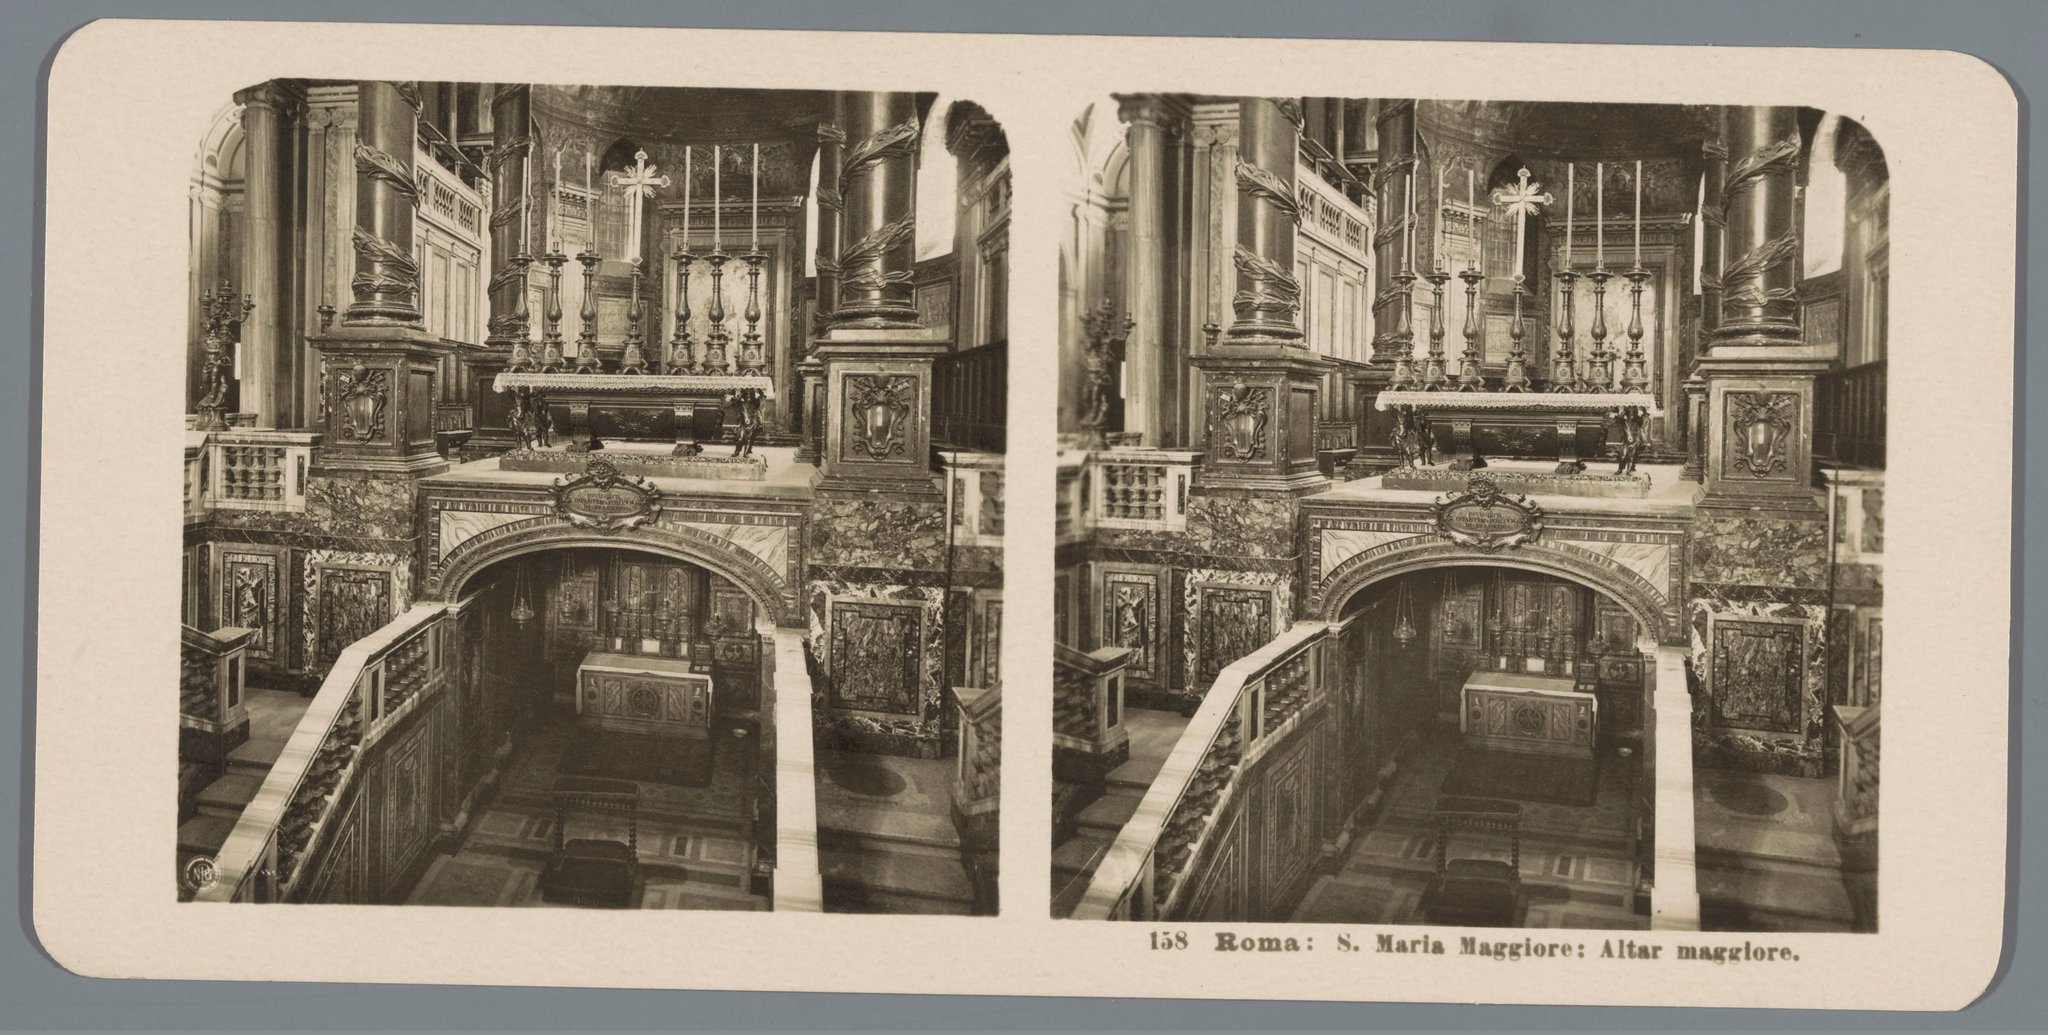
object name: stereograph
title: Roma: S. Maria Maggiore: altar maggiore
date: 1900-1910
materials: cardboard, photographic support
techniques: gelatin silver print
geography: santa maria maggiore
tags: interior of church, altar with altar-piece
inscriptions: number: ‘158’, inscription: ‘NPG’